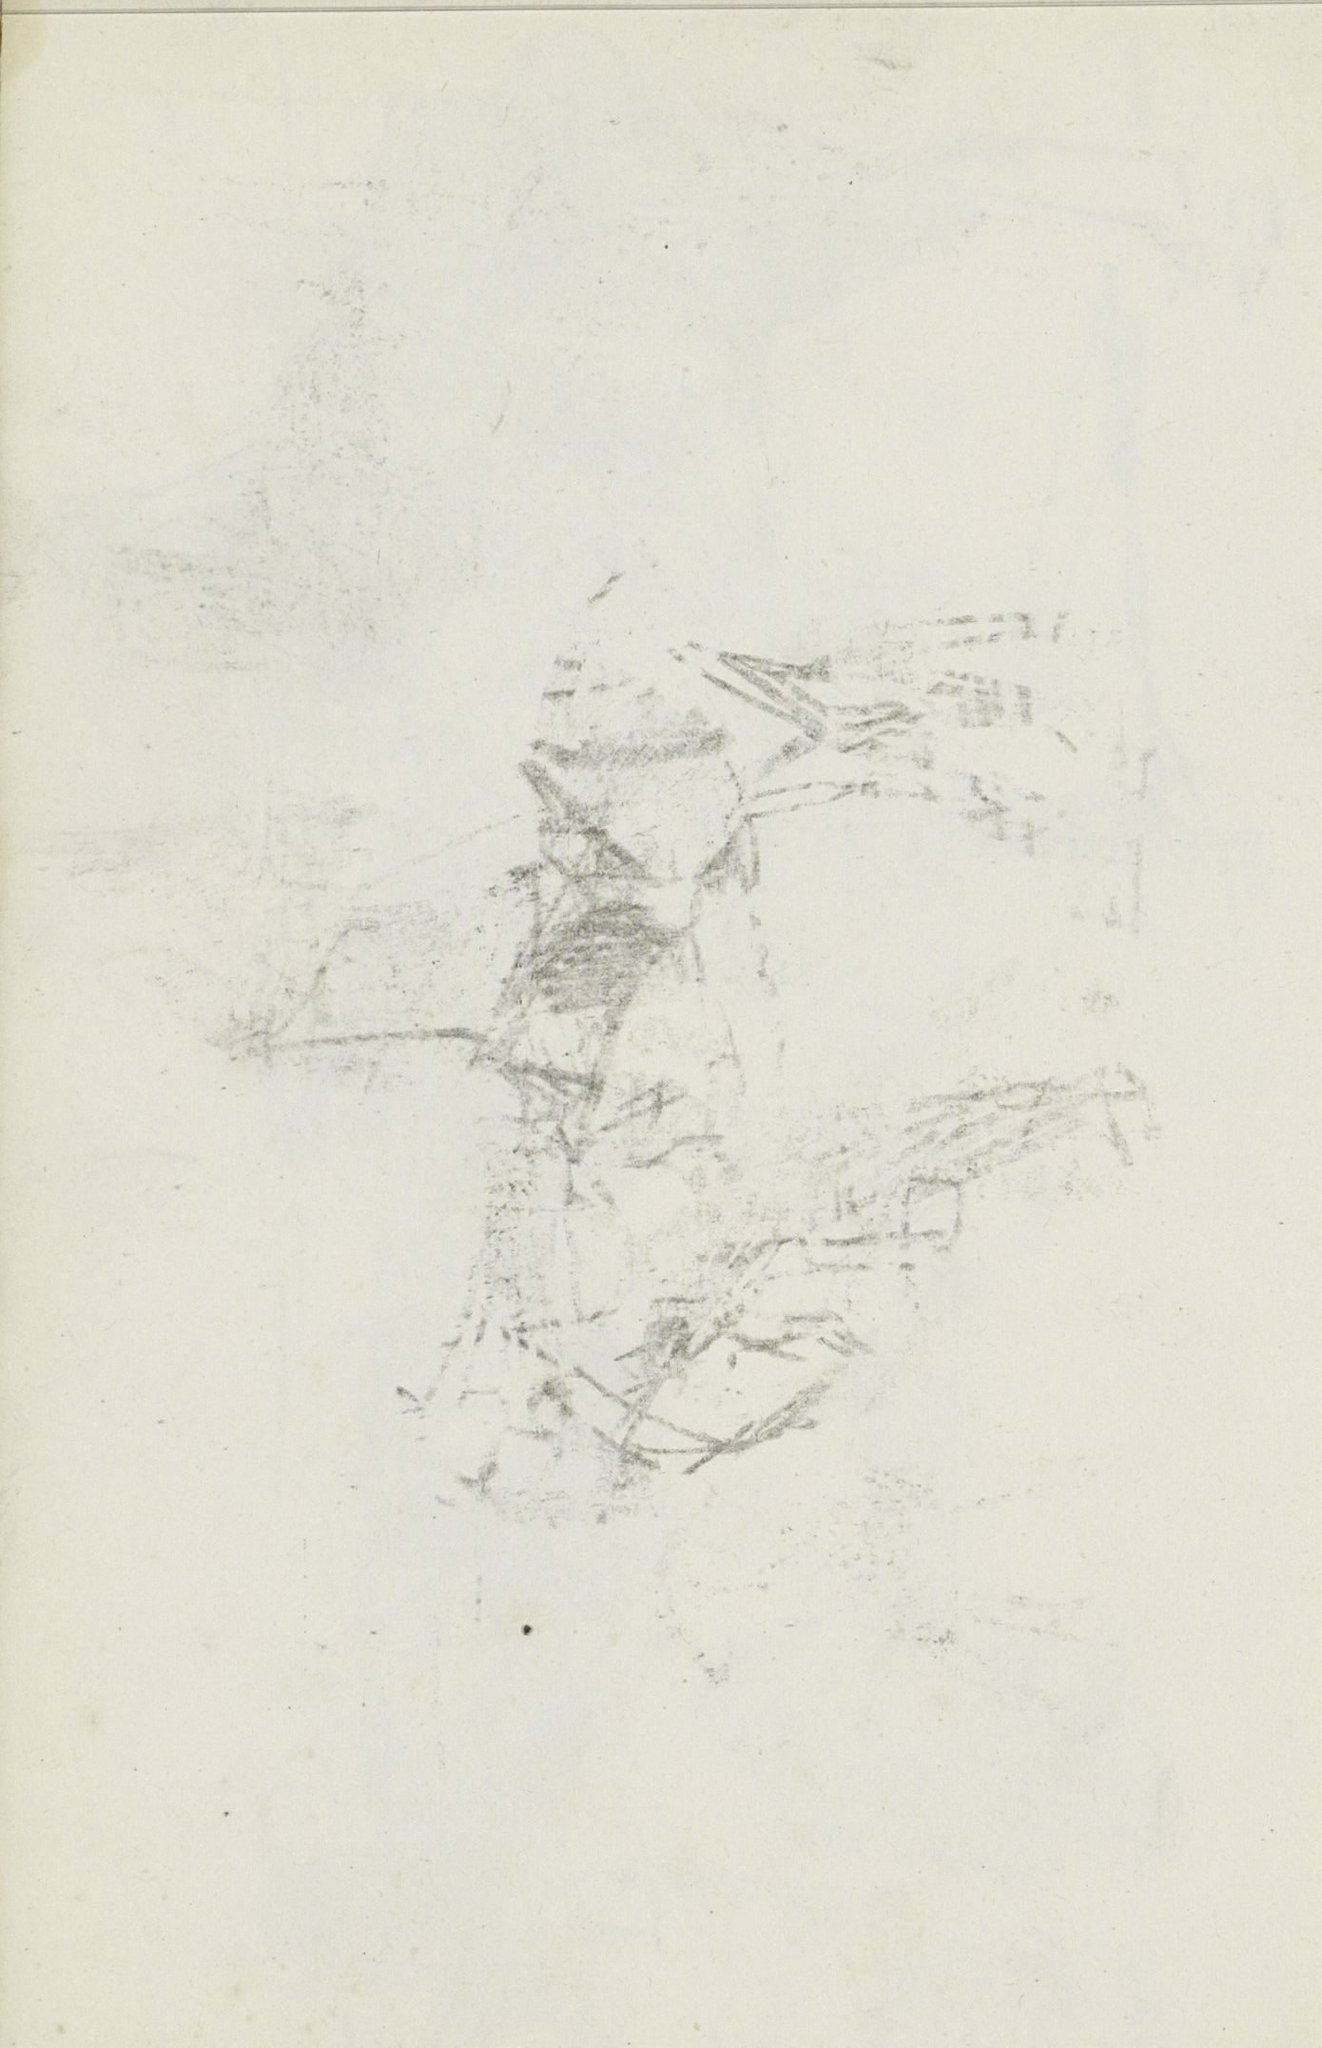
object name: sketchbook leaf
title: Abklatsch van de krijttekening op blad 8 recto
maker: isaac israels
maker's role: draughtsman, painter, print maker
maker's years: 1865-1934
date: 1875-1934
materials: paper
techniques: printmaking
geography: london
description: Pagina 21 en pagina 22 uit schetsboek XXXV met 36 pagina's.